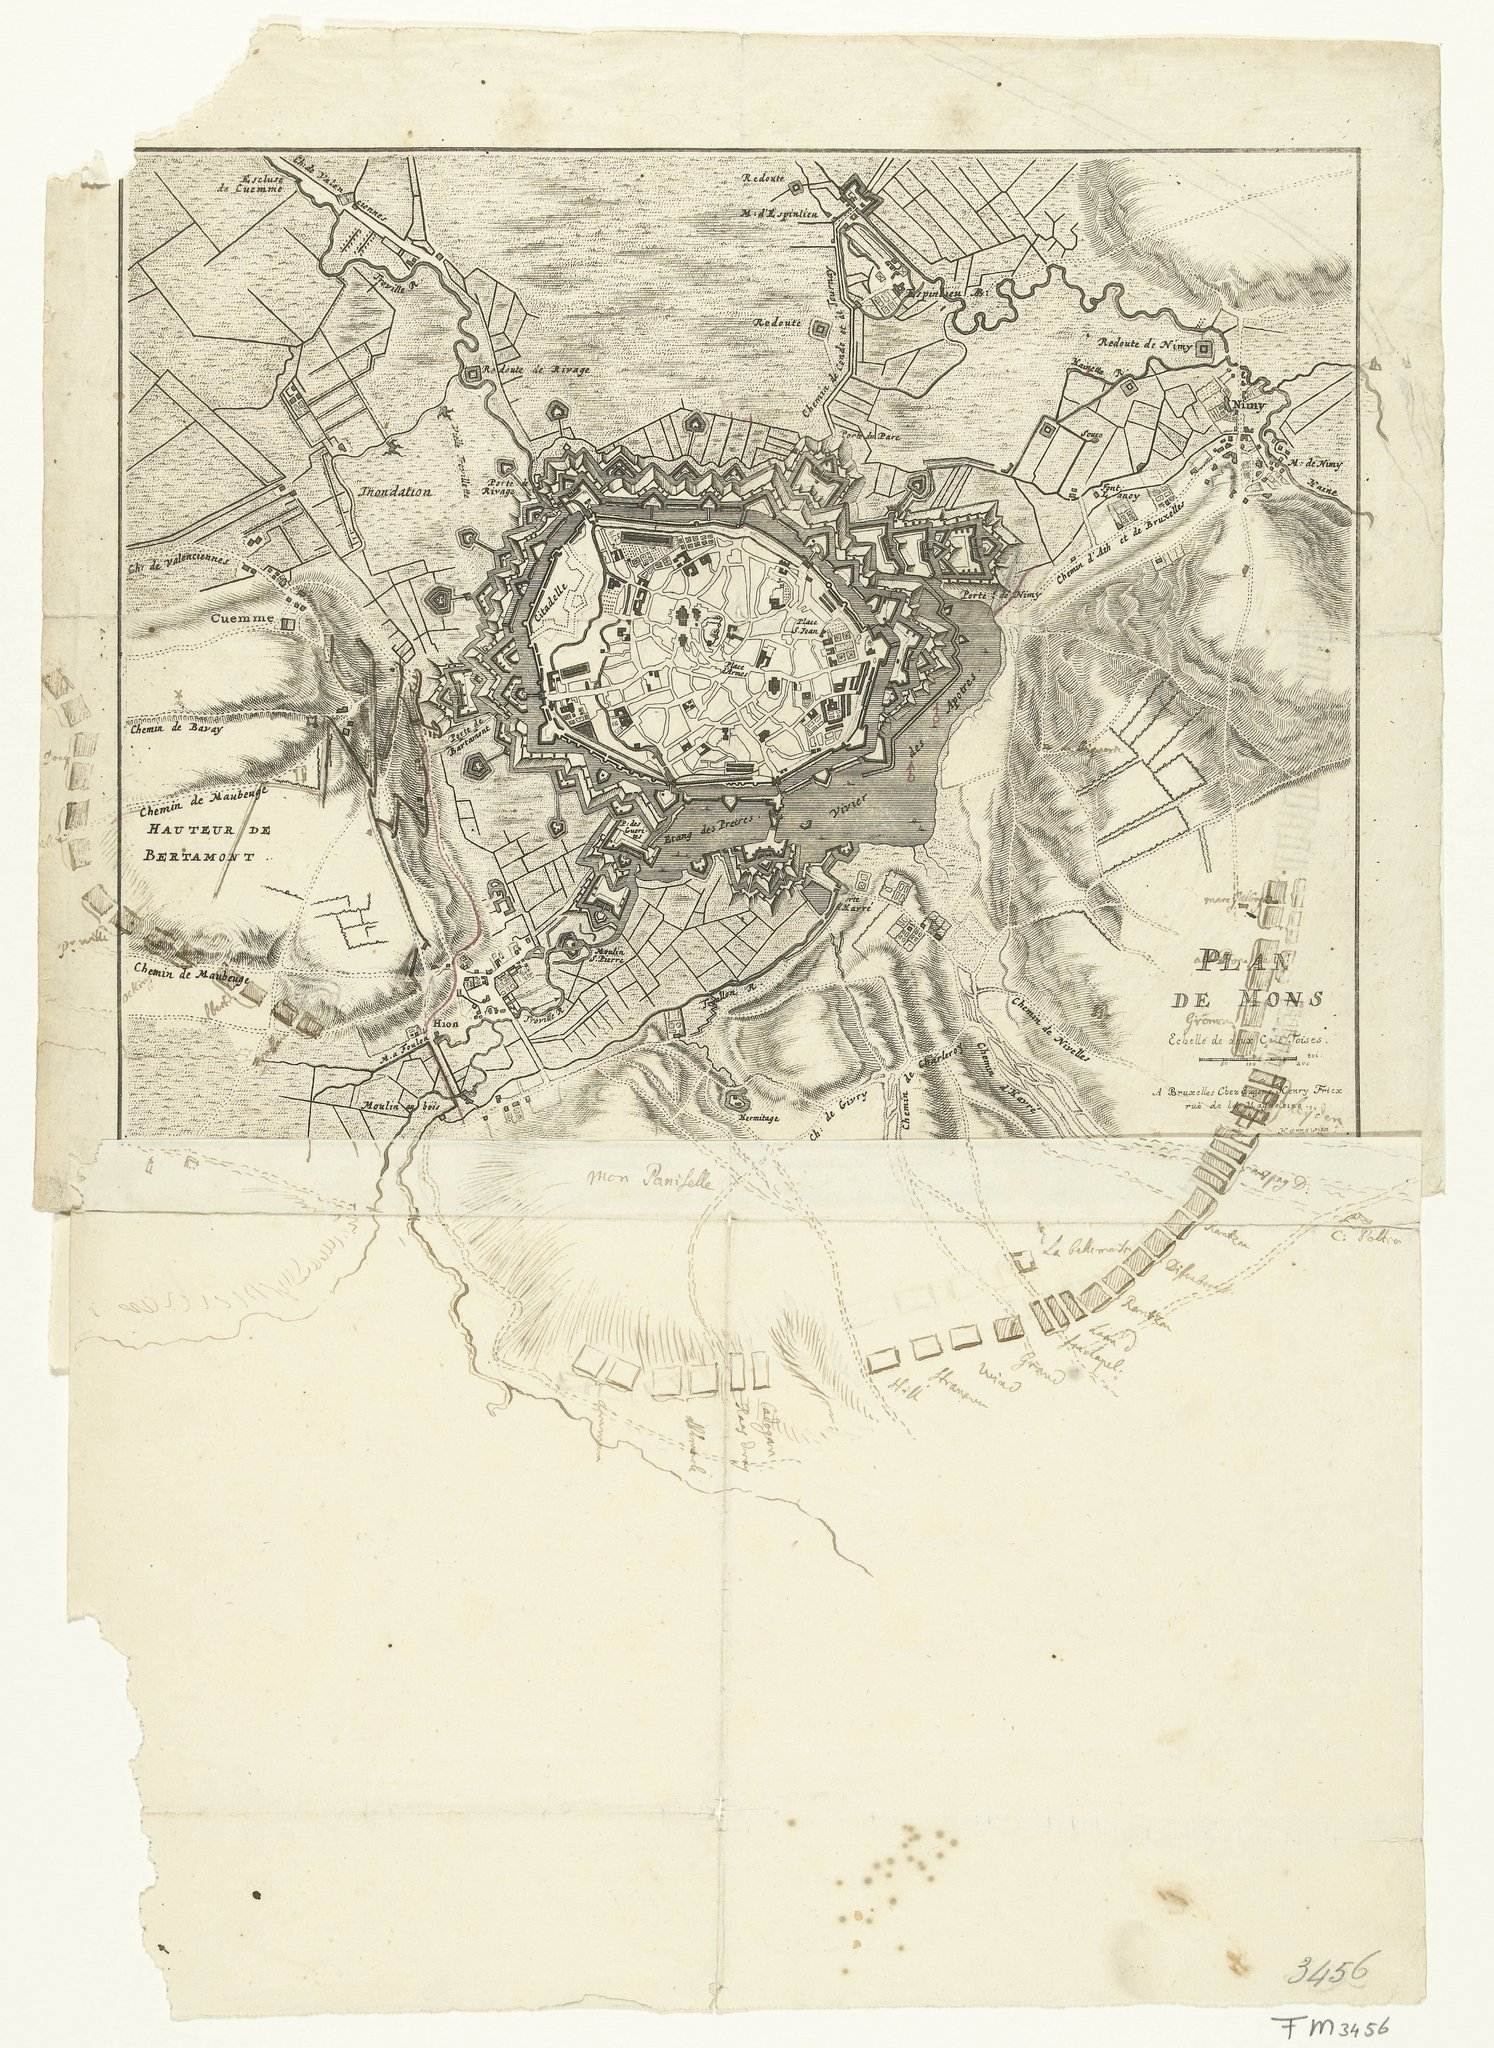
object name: print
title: Plan de Mons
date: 1709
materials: ink, paper, pencil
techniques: etching, pen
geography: brussels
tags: siege, position war, maps of cities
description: Kaart van Mons (Bergen) waarop de ligging van de belegerende Geallieerde troepen in bijgetekend, september-oktober 1709. Aan de onderzijde van de prent is een blad geplakt met een getekende aanvulling op de kaart.